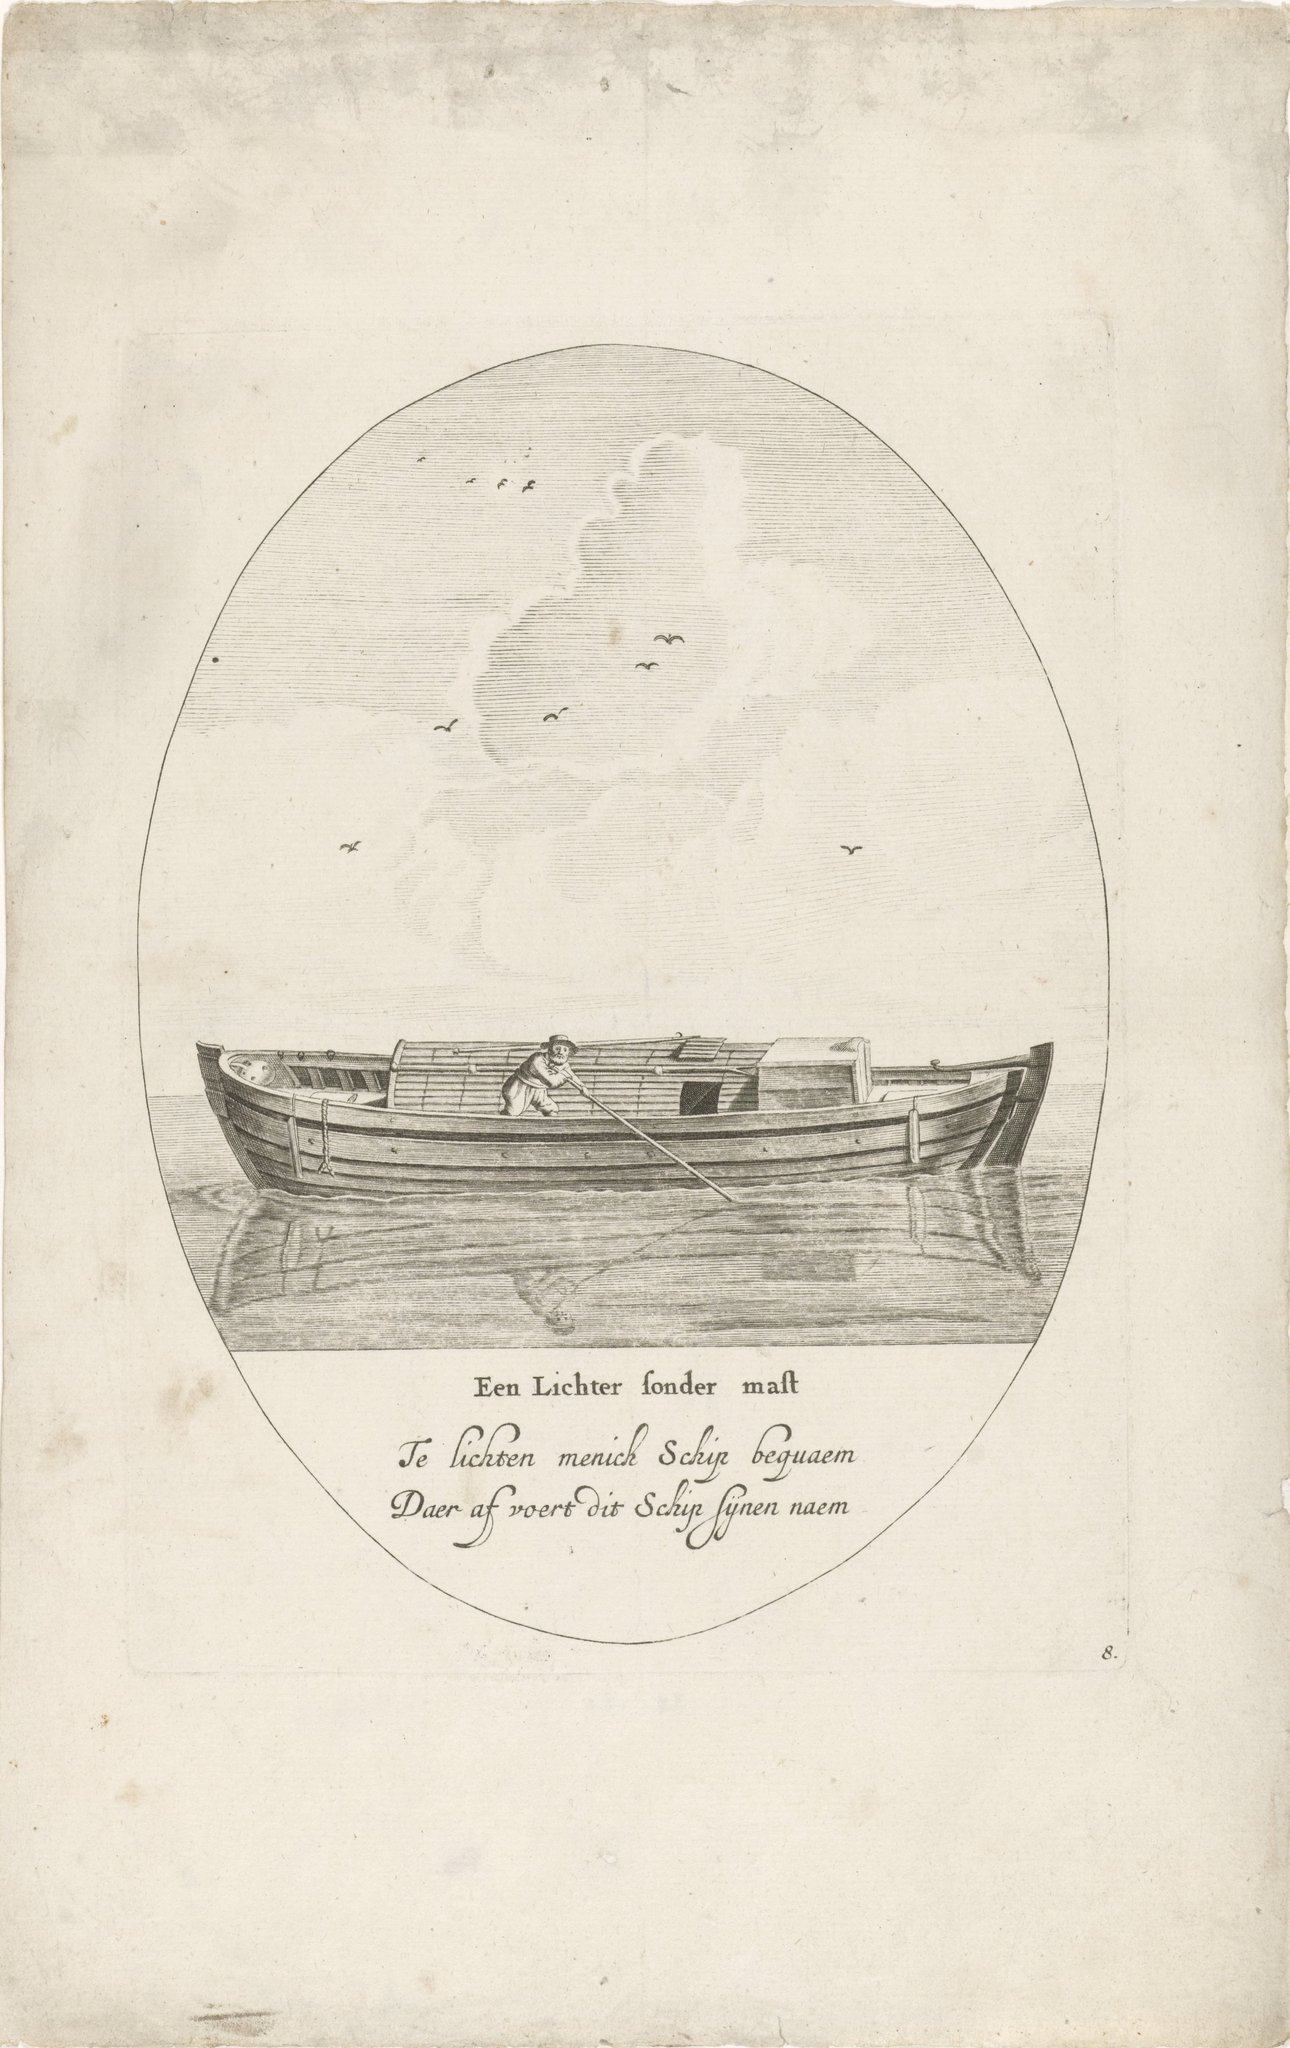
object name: print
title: Acht verschillende Hollandse typen binnenvaartschepen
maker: dirk eversen lons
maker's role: print maker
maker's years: 1599-1686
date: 1609-1686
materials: paper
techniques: engraving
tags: sailing-ship, sailing-boat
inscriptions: collector's mark: Lugt 2228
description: Een lichter zonder mast, door een opvarende vooruit geboomd. Onder de voorstelling een tweeregelig Nederlands vers.